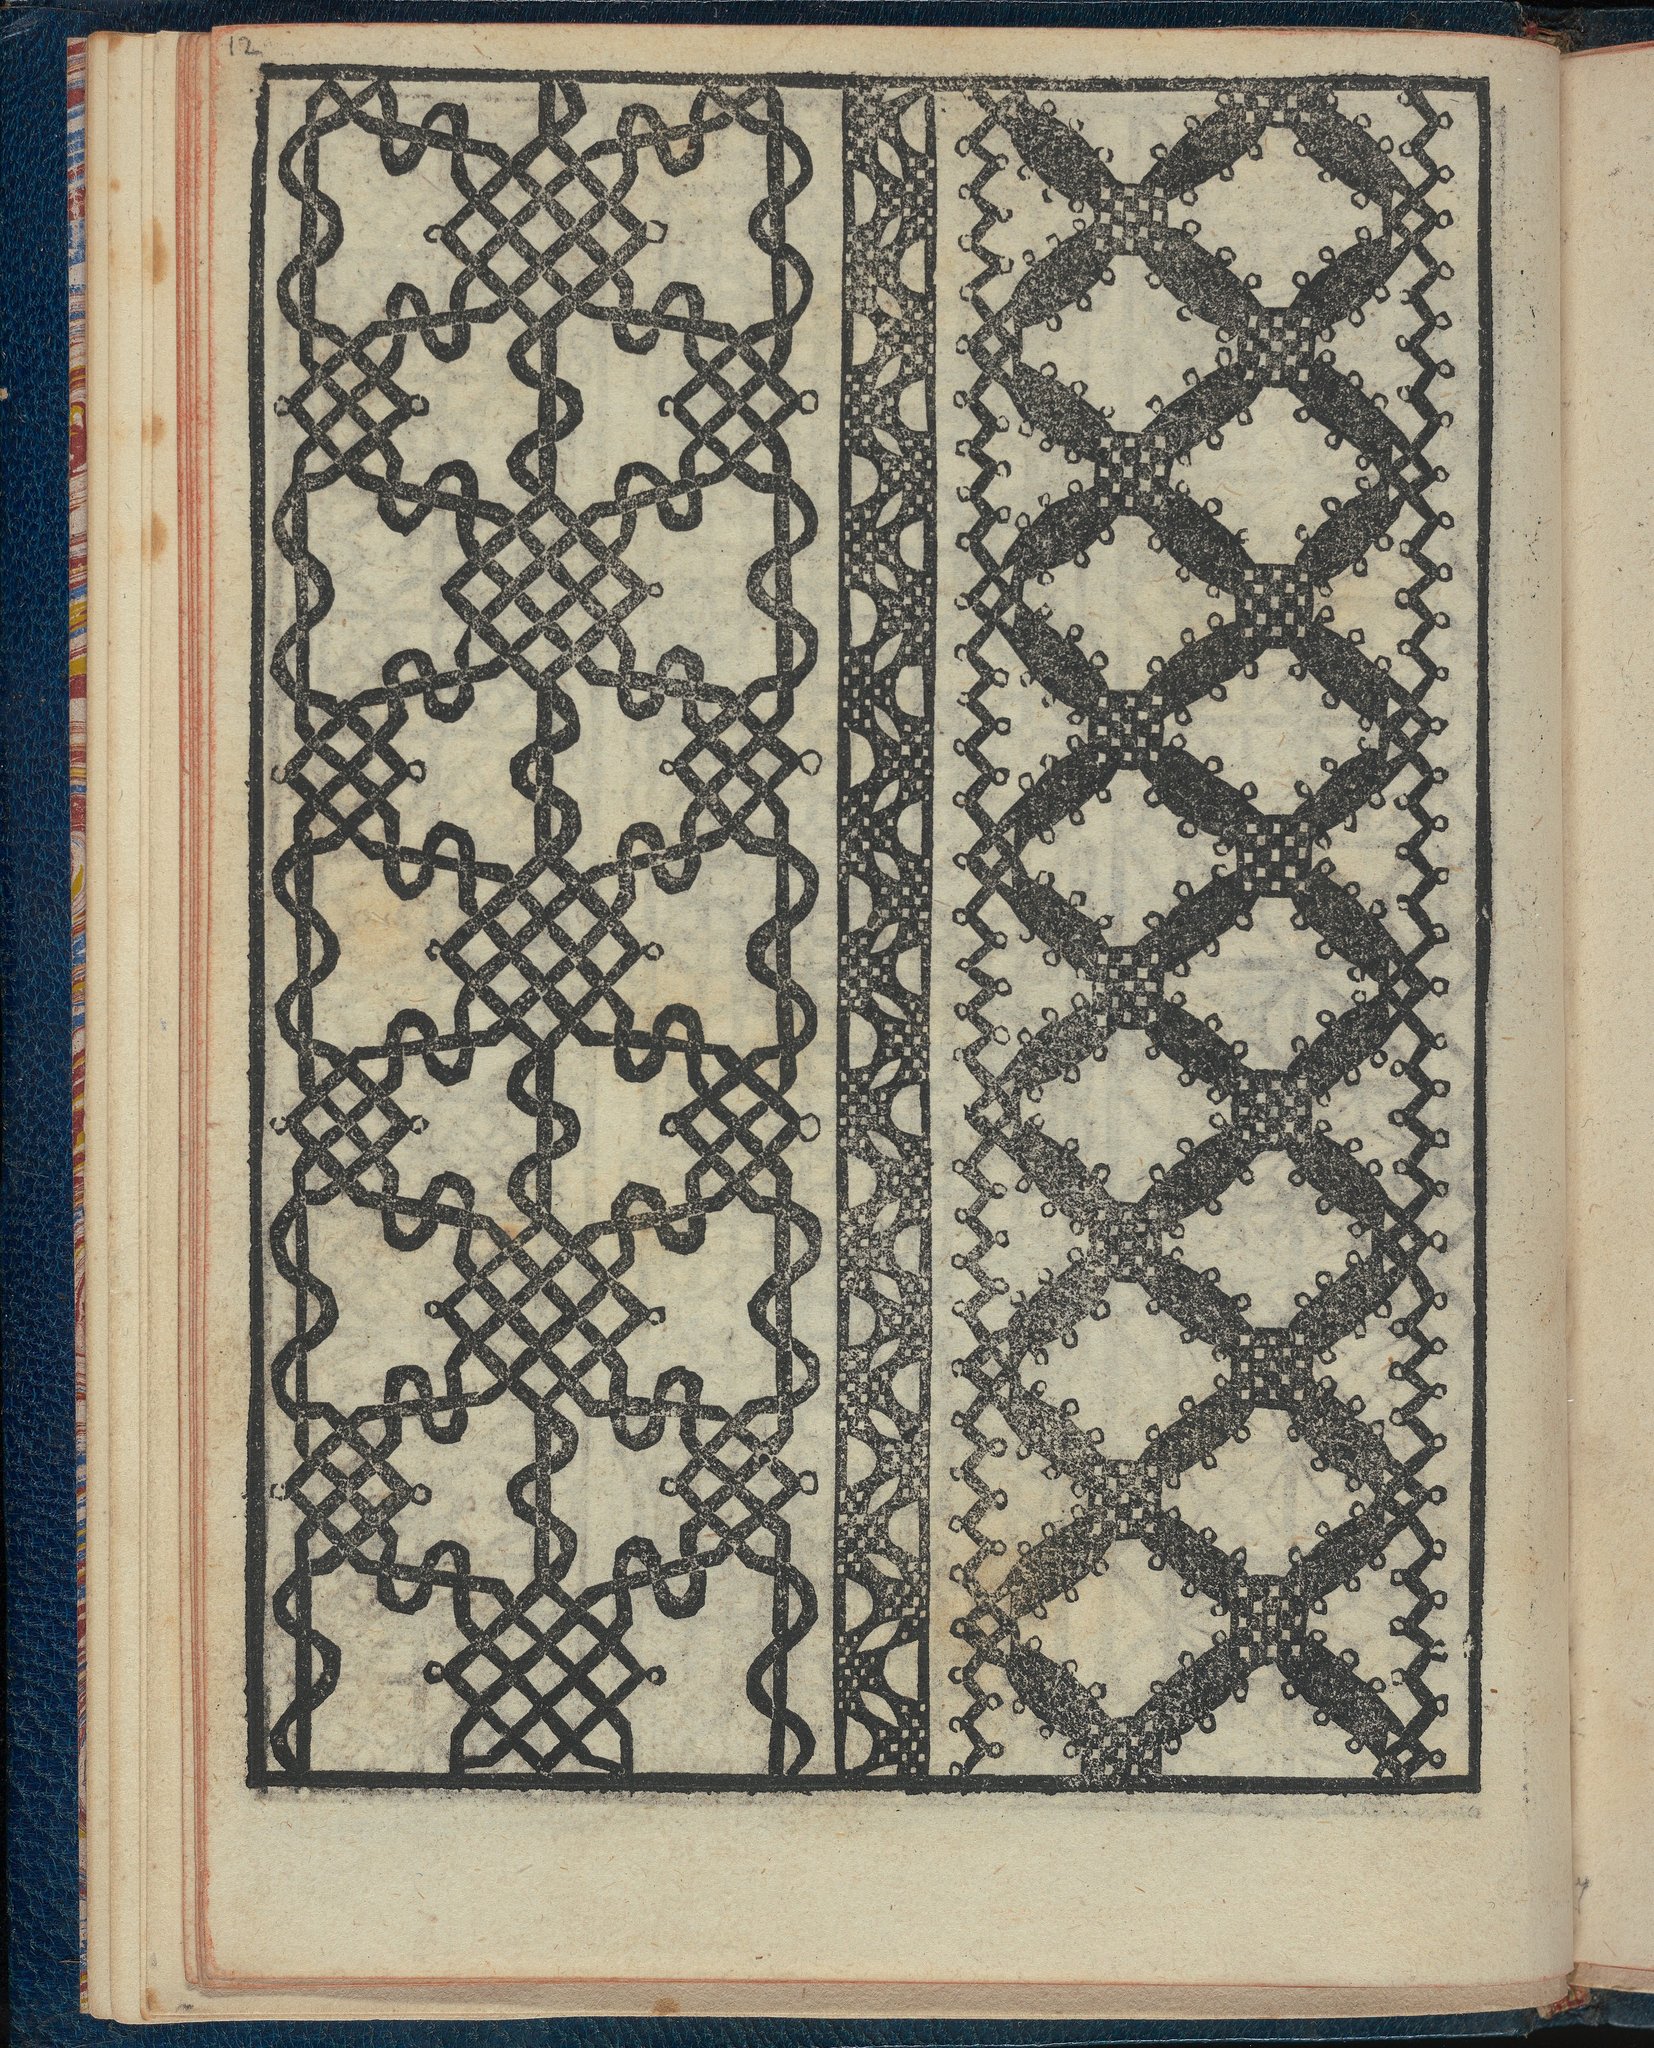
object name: book print ornament architecture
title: Le Pompe: Opera Nova, page 6 (verso)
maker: giovanni battista & marchio sessa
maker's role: publisher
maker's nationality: italian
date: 1557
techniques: woodcut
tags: ornament